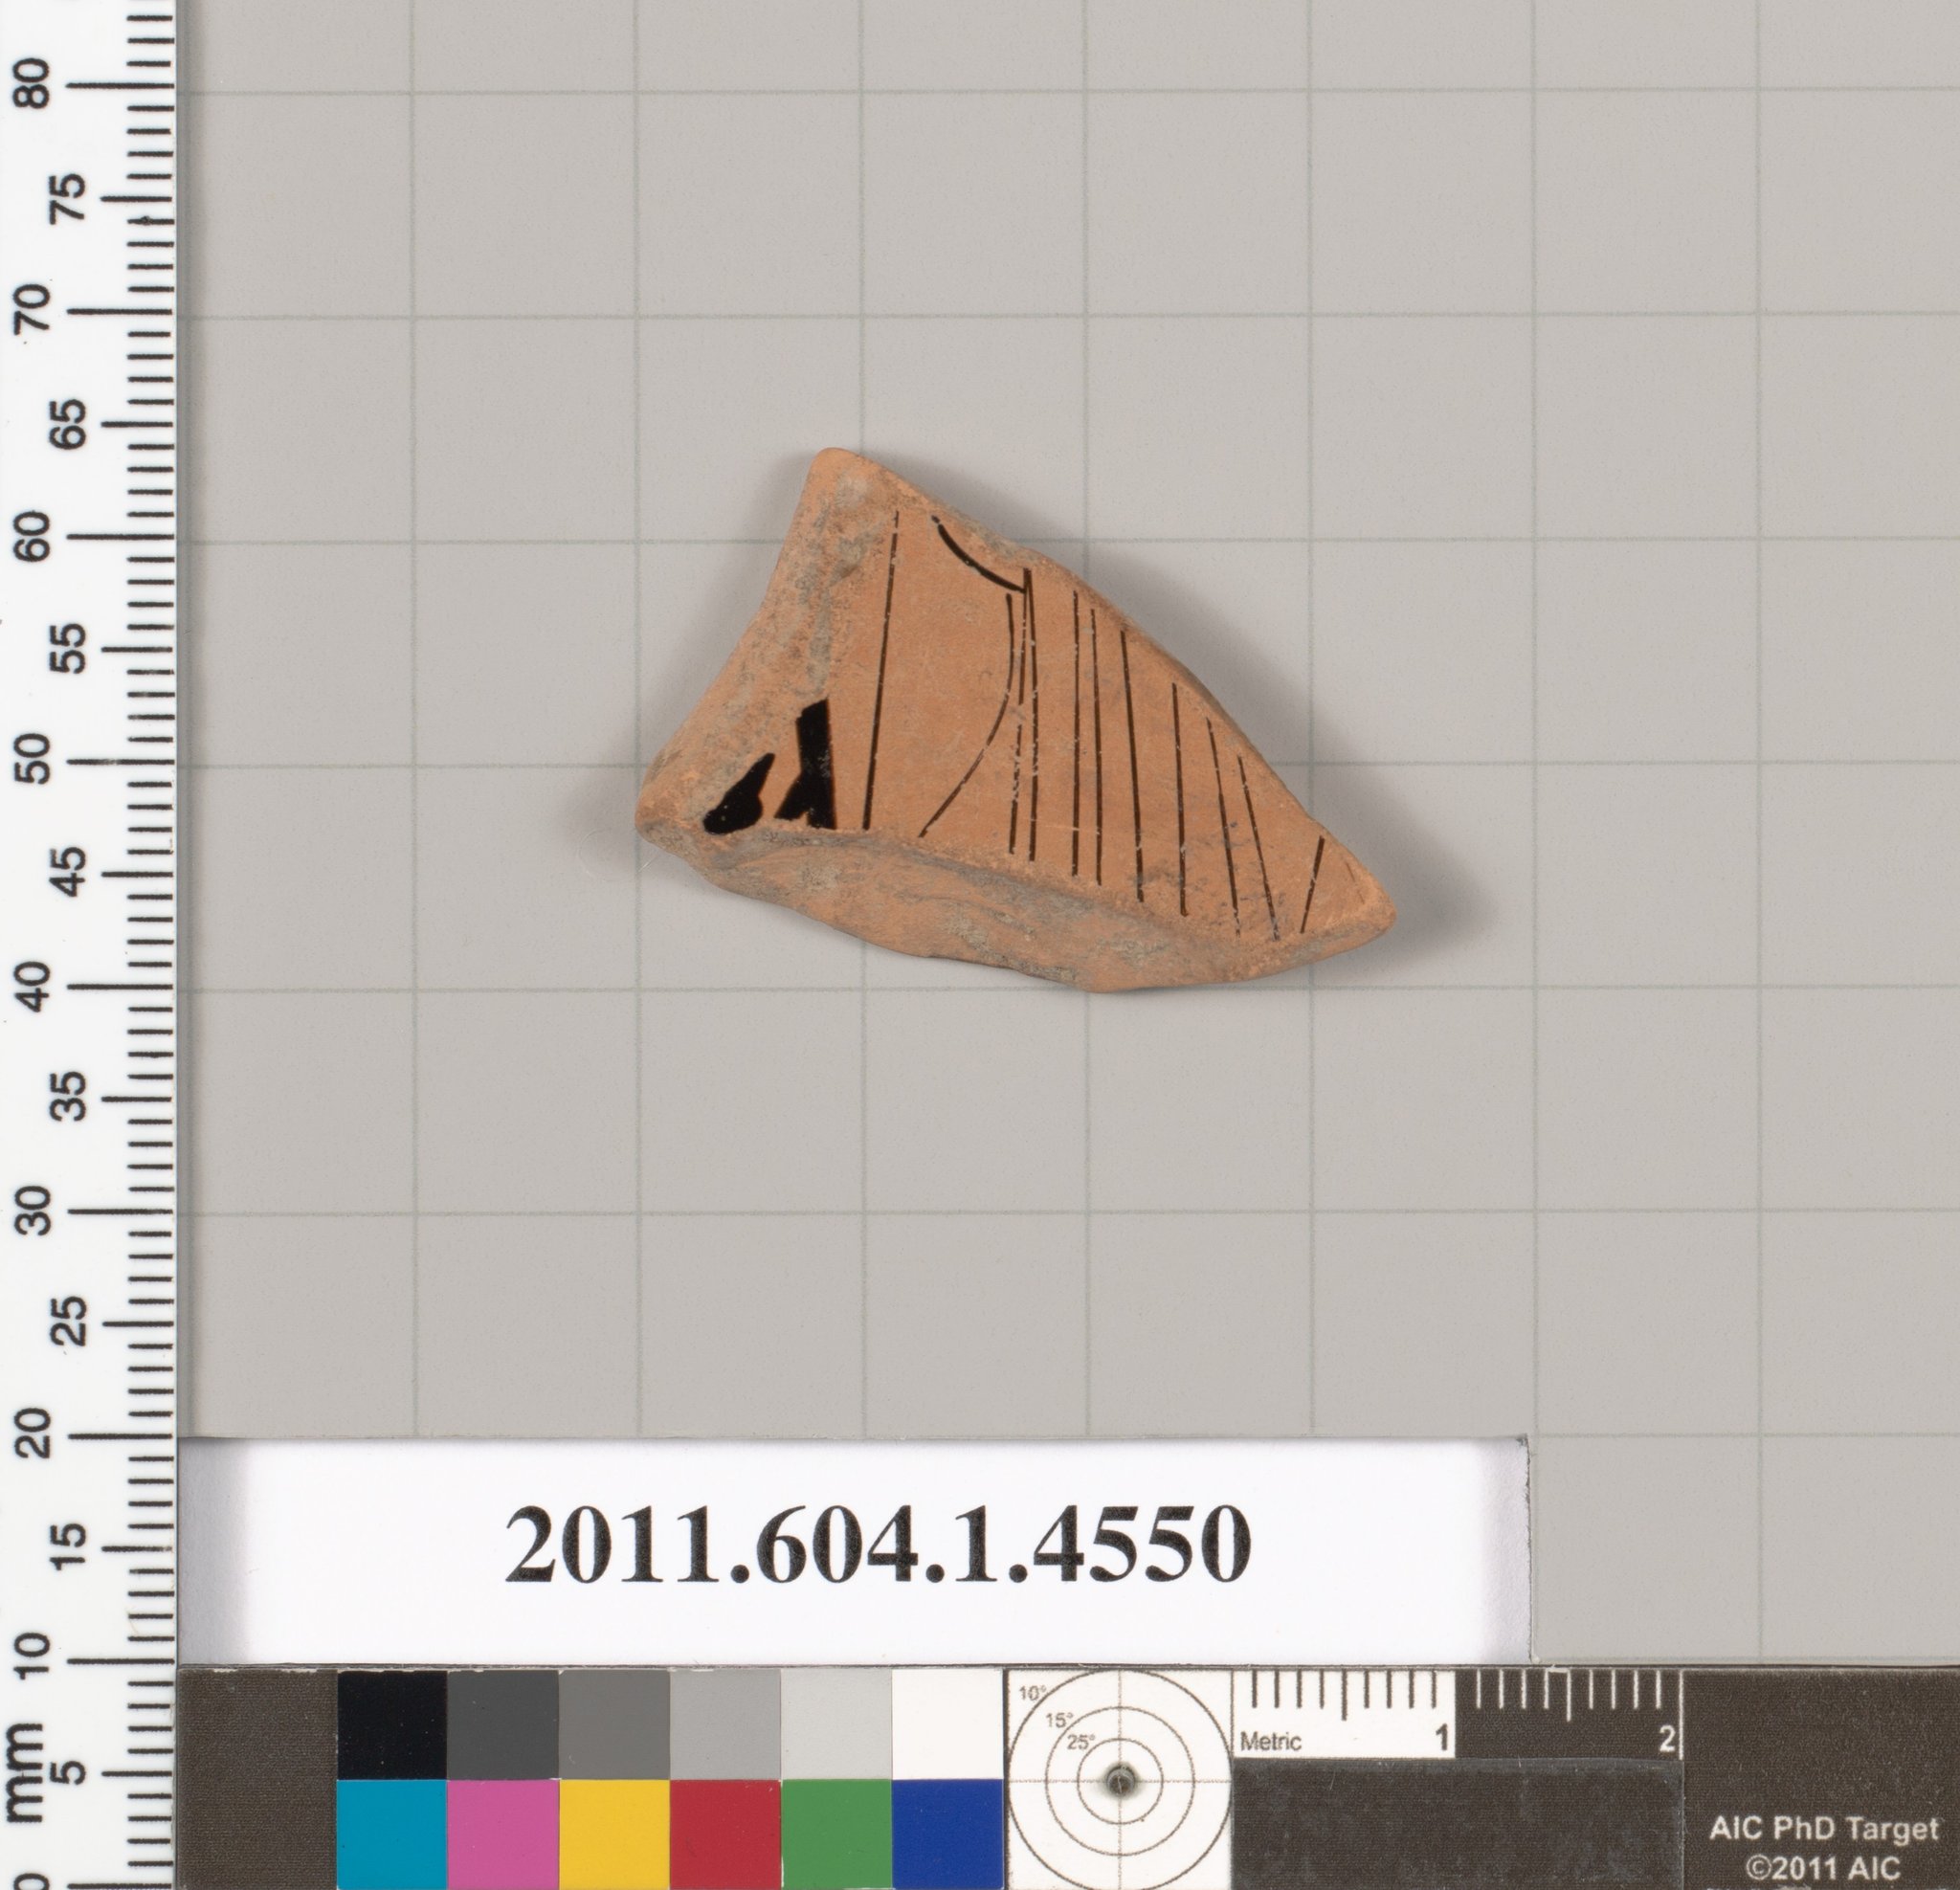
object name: kylix fragment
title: Terracotta fragment of a kylix (drinking cup)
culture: greek, attic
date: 475-451 BCE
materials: terracotta